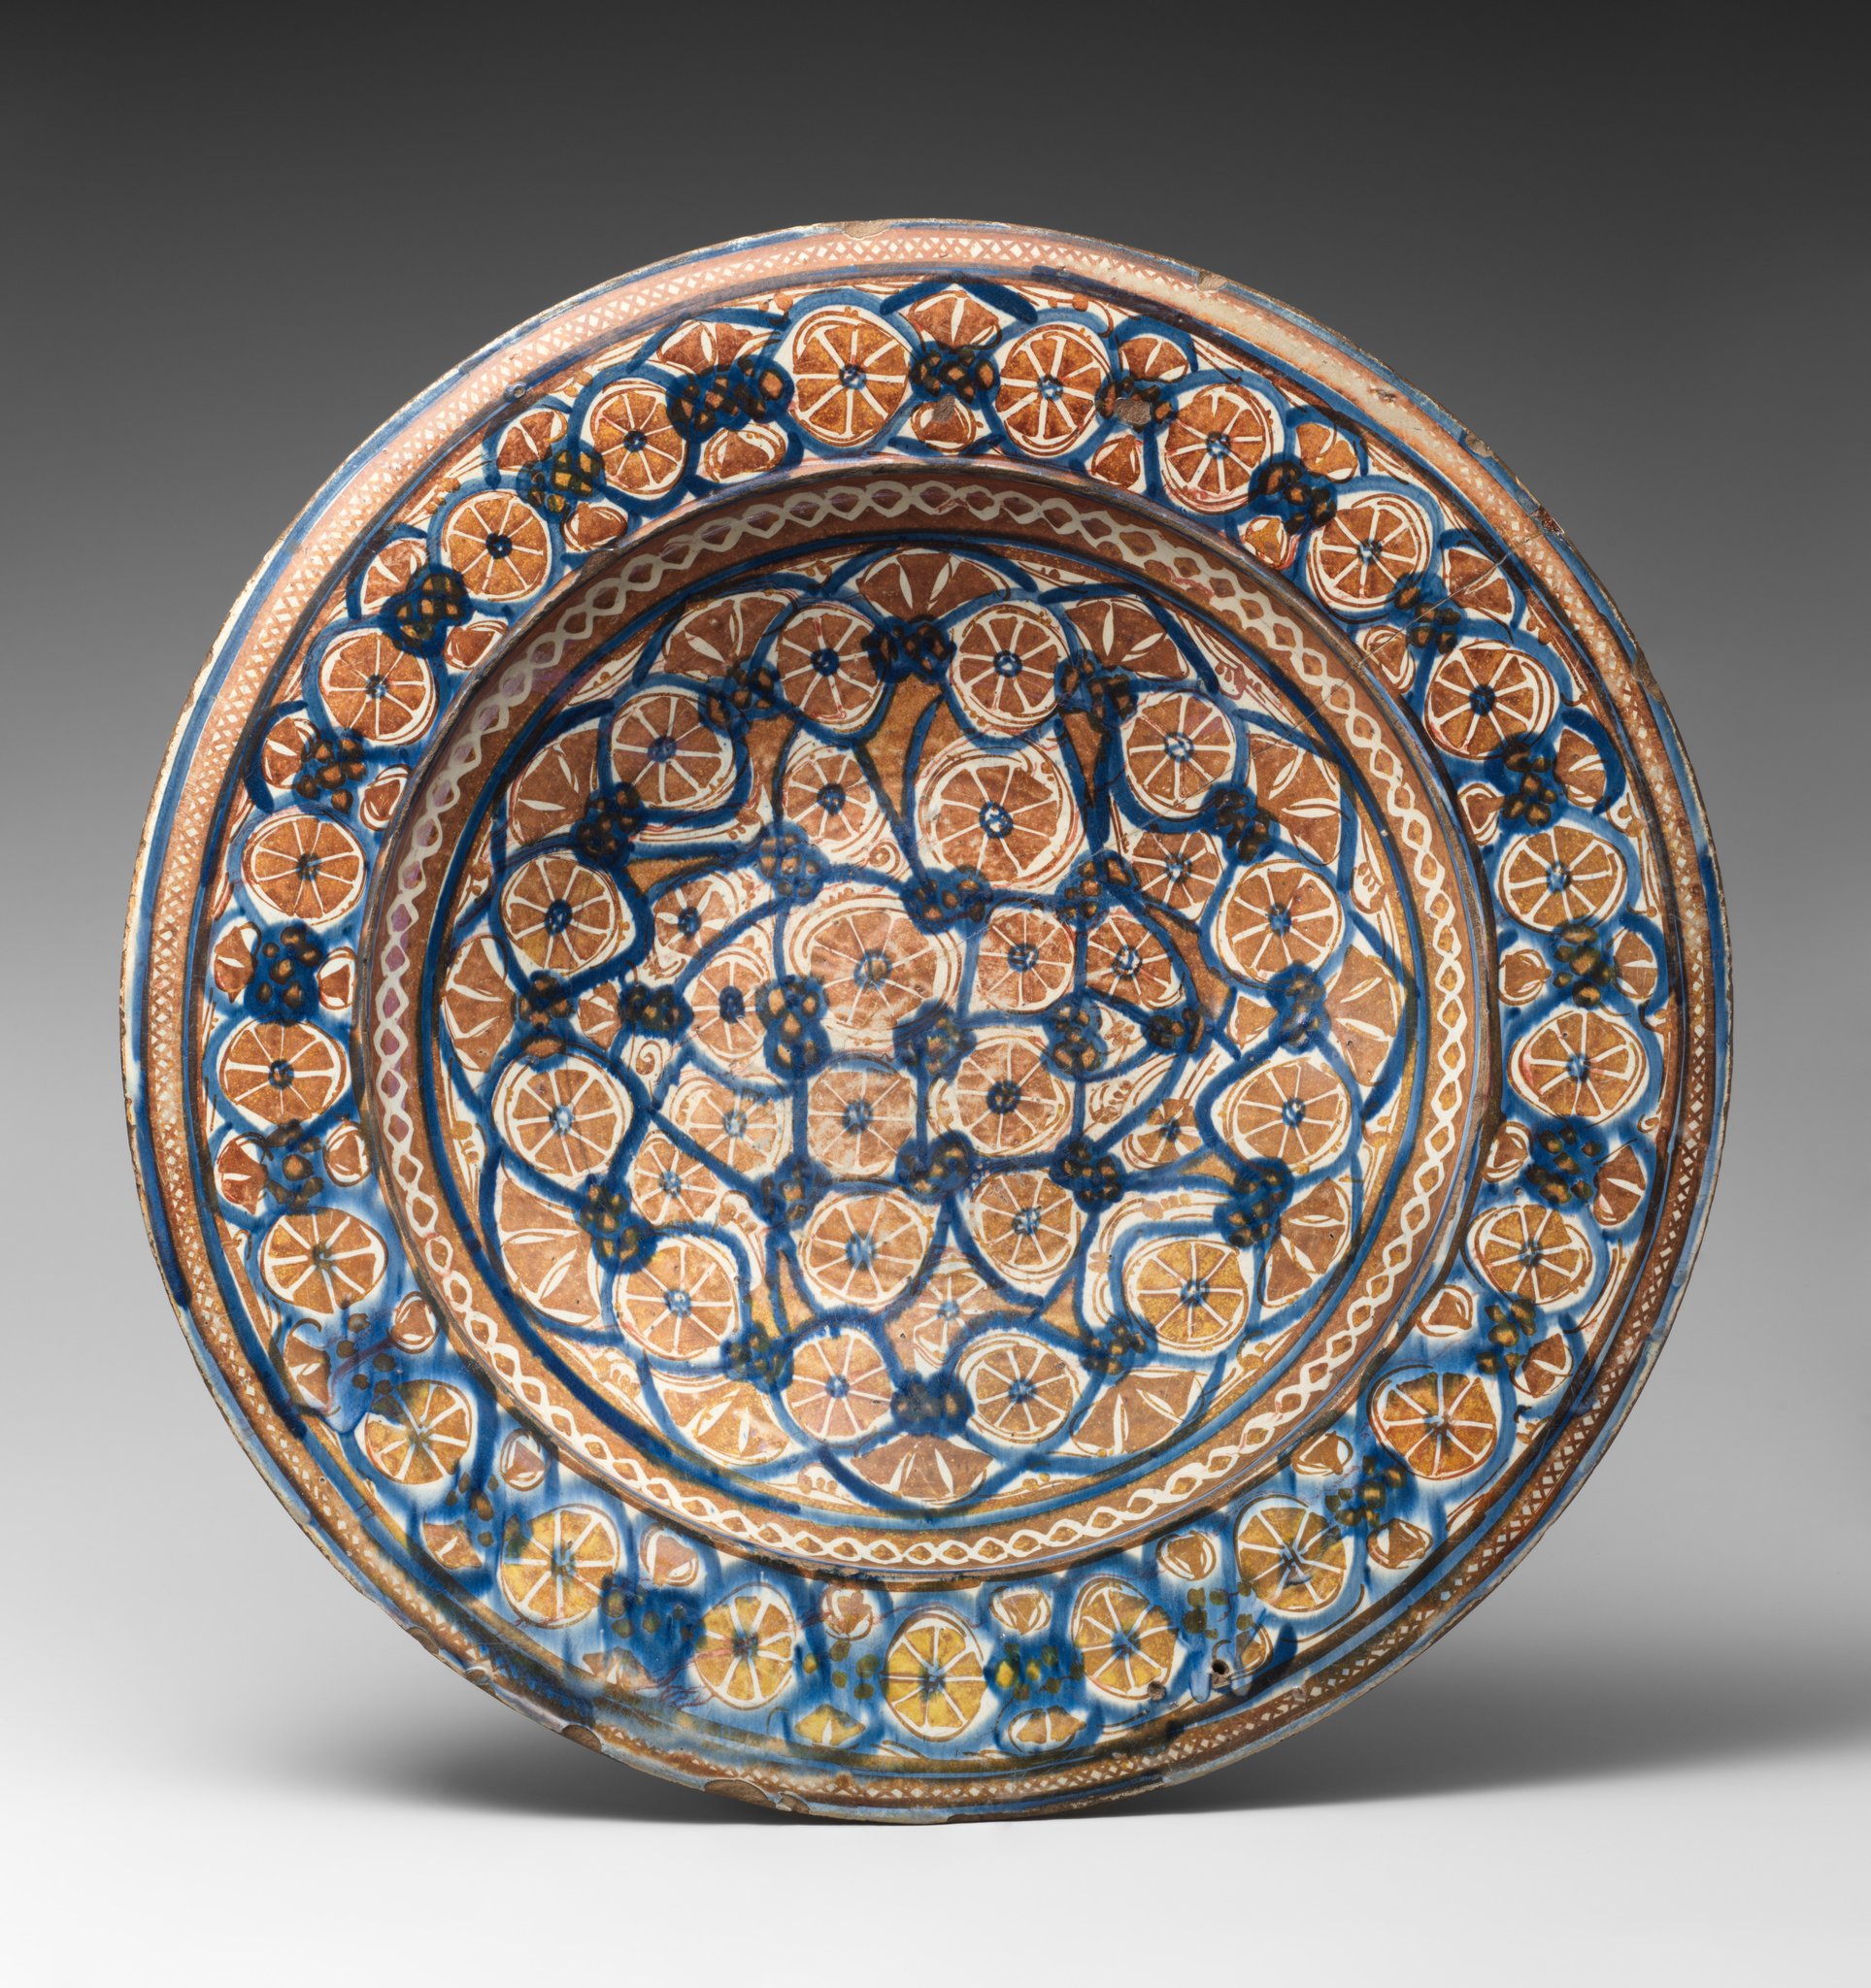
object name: plate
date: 1401-1433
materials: earthenware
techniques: luster painting, glazing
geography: spain